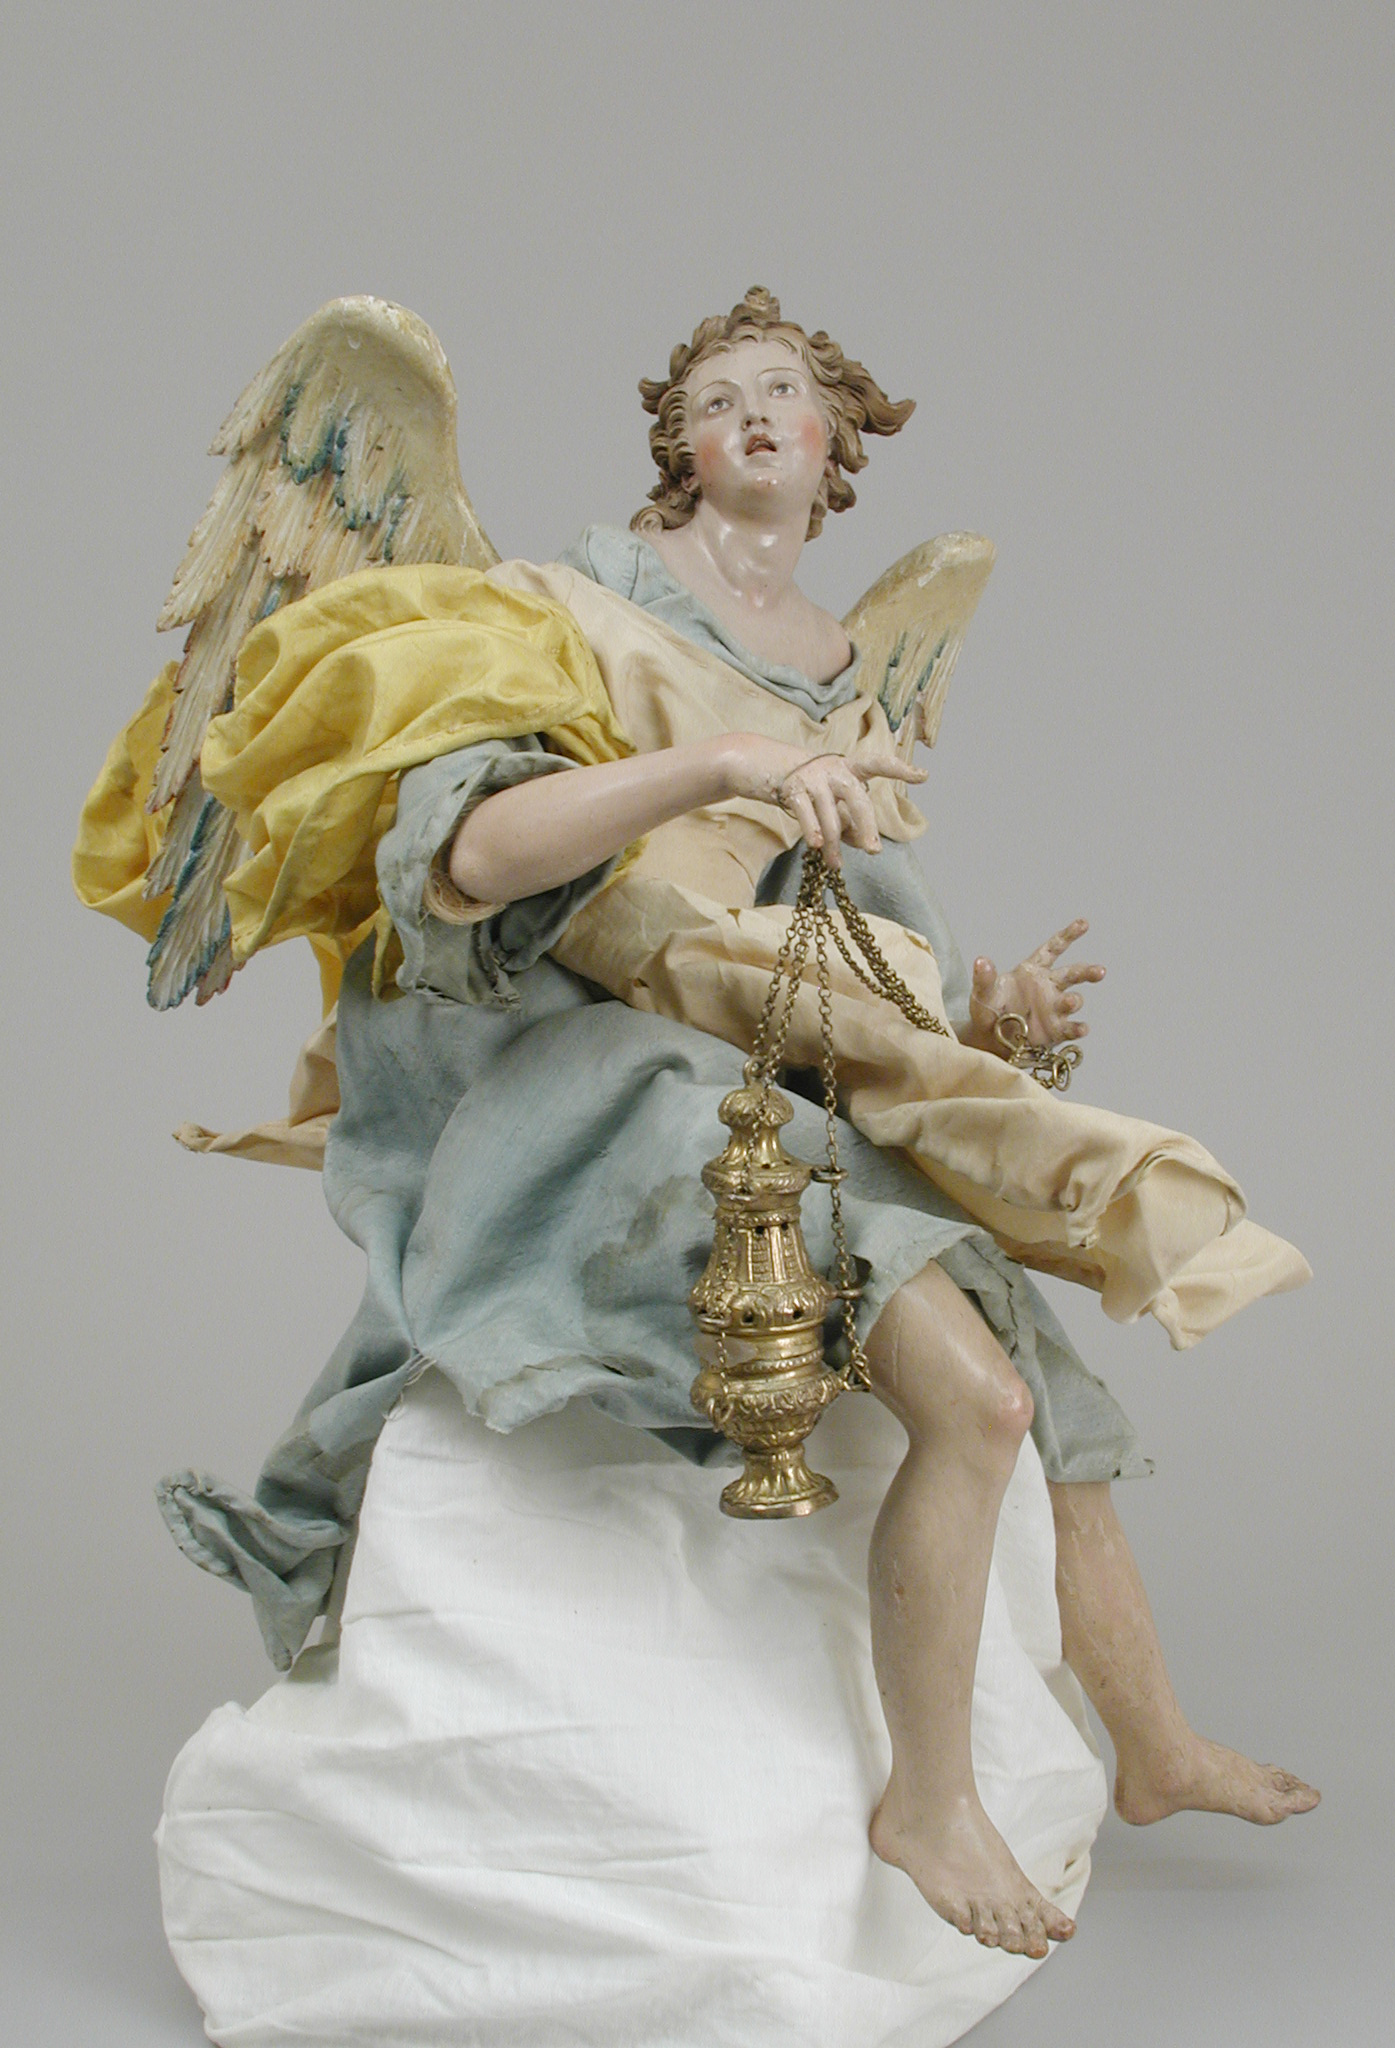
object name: crèche figure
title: Angel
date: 1751-1800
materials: terracotta, fiber, metal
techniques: polychrome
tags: angels,censers